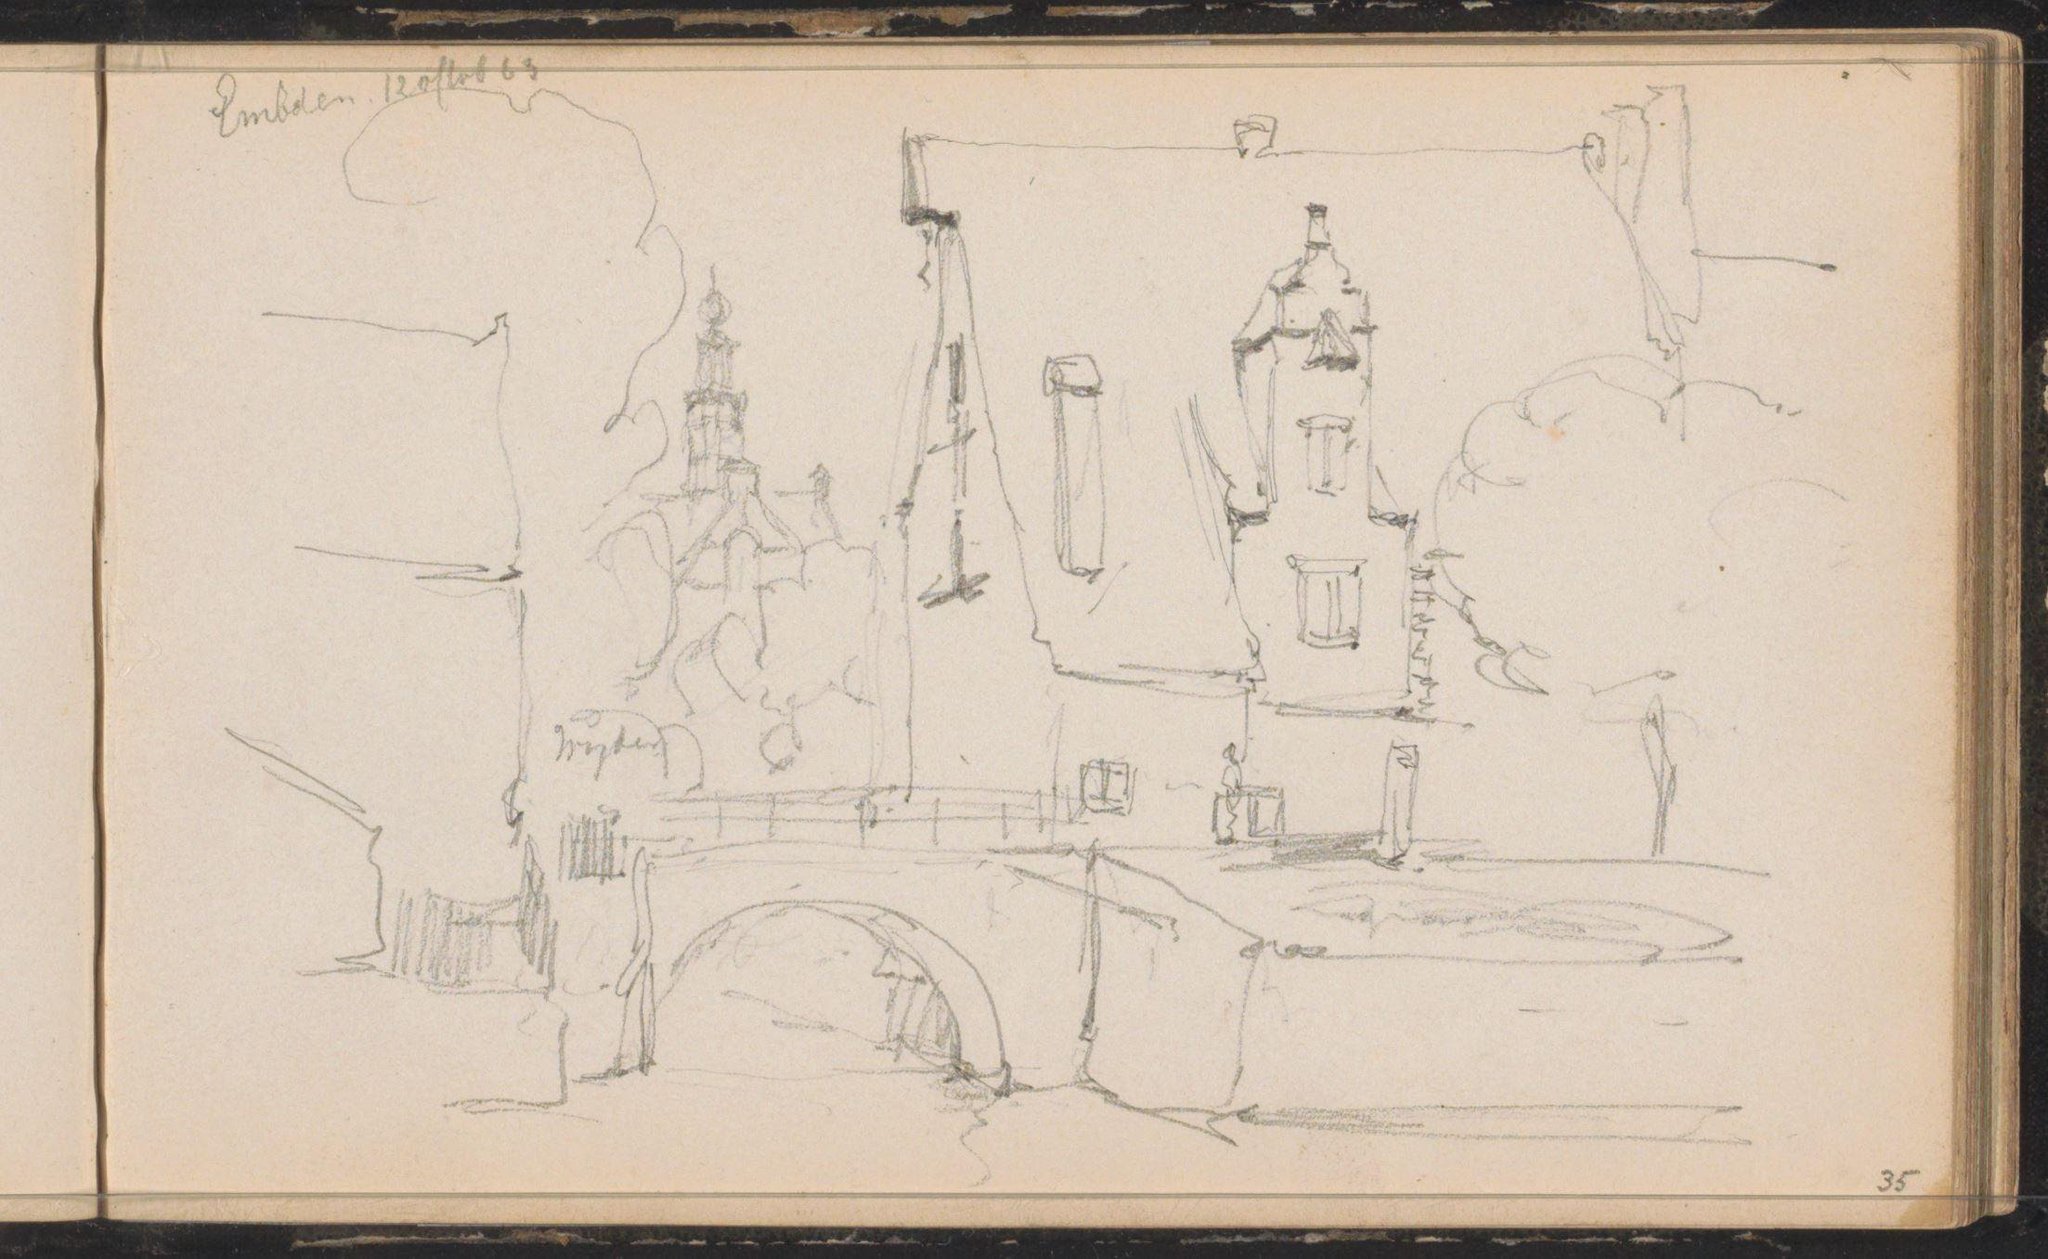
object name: sketchbook leaf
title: Gezicht op Emden met de Nieuwe Kerk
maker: cornelis springer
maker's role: draughtsman, painter, print maker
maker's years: 1817-1891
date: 1863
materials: paper, pencil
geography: emden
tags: church (exterior), bridge in city across river, canal, etc.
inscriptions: date: ‘12 octob 63’, annotation: ‘Embden [sic]’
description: Gezicht op Emden met de Nieuwe Kerk. Blad 35 uit een schetsboek met 55 bladen vervaardigd op de Veluwe en in Noord-Duitsland.